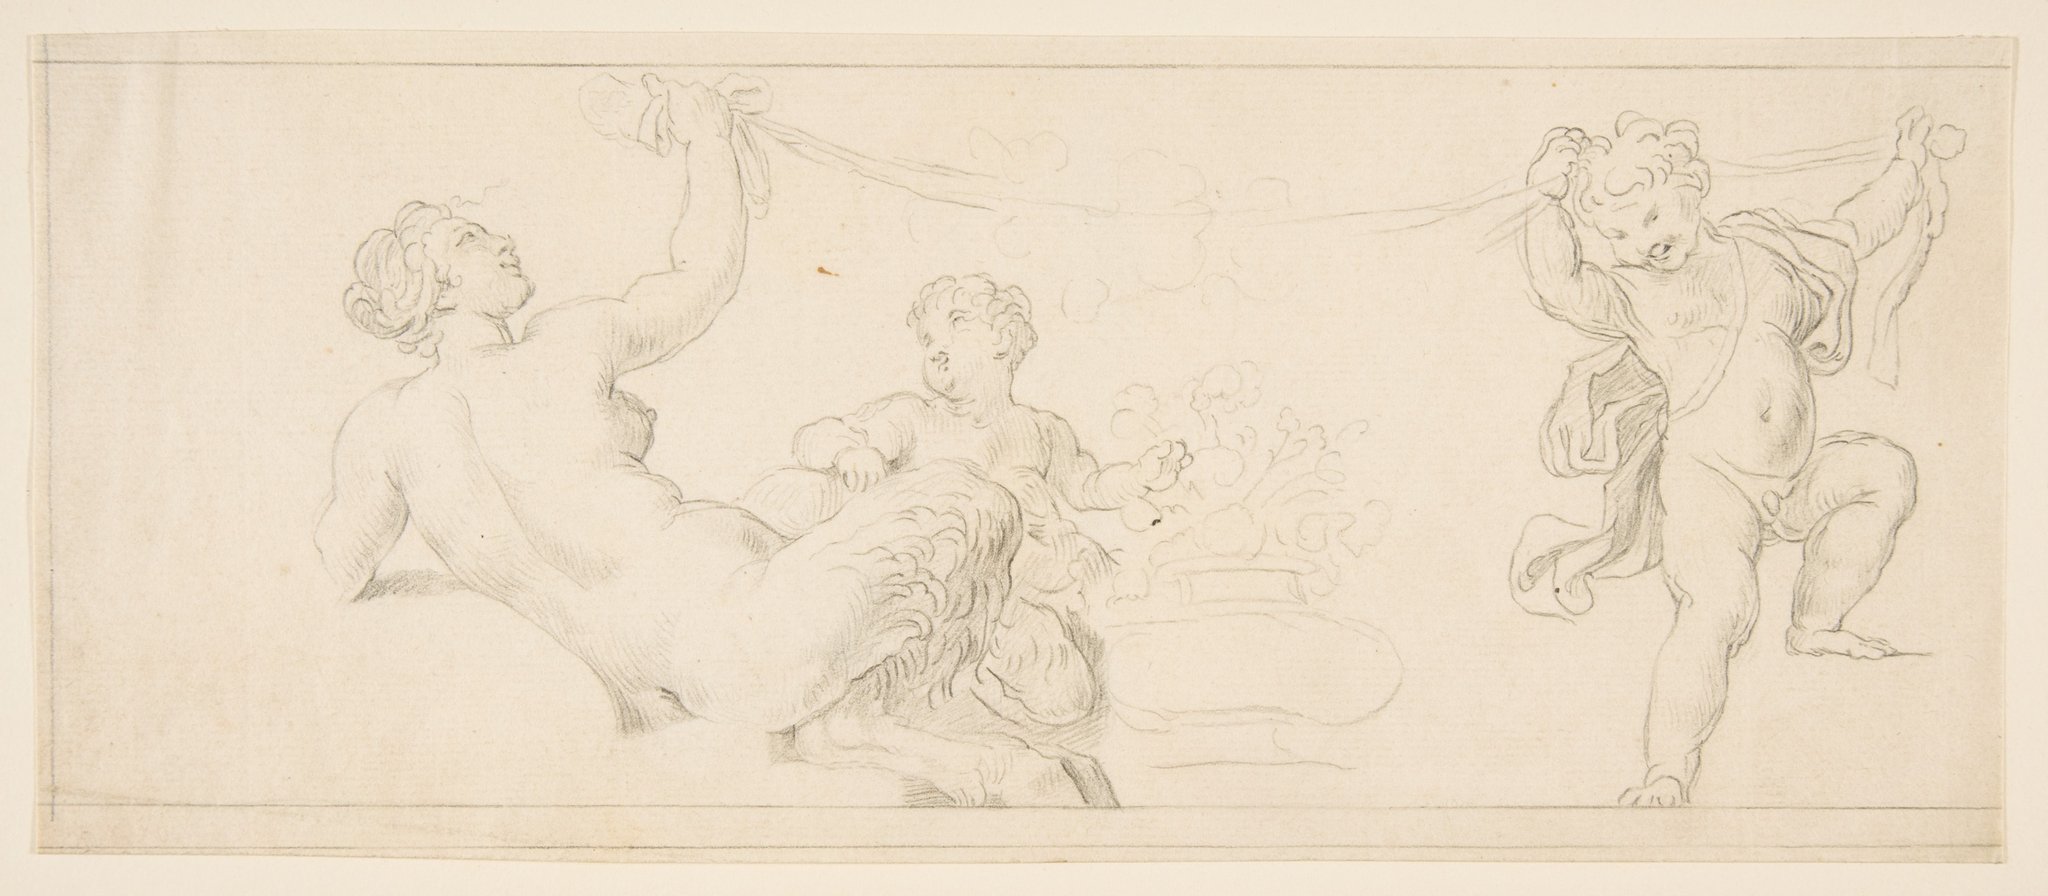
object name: drawing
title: Design for a Frieze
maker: anonymous, french, 18th century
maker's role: artist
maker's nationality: french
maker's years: 1700-1800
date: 1701-1800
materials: chalk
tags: putti,satyrs